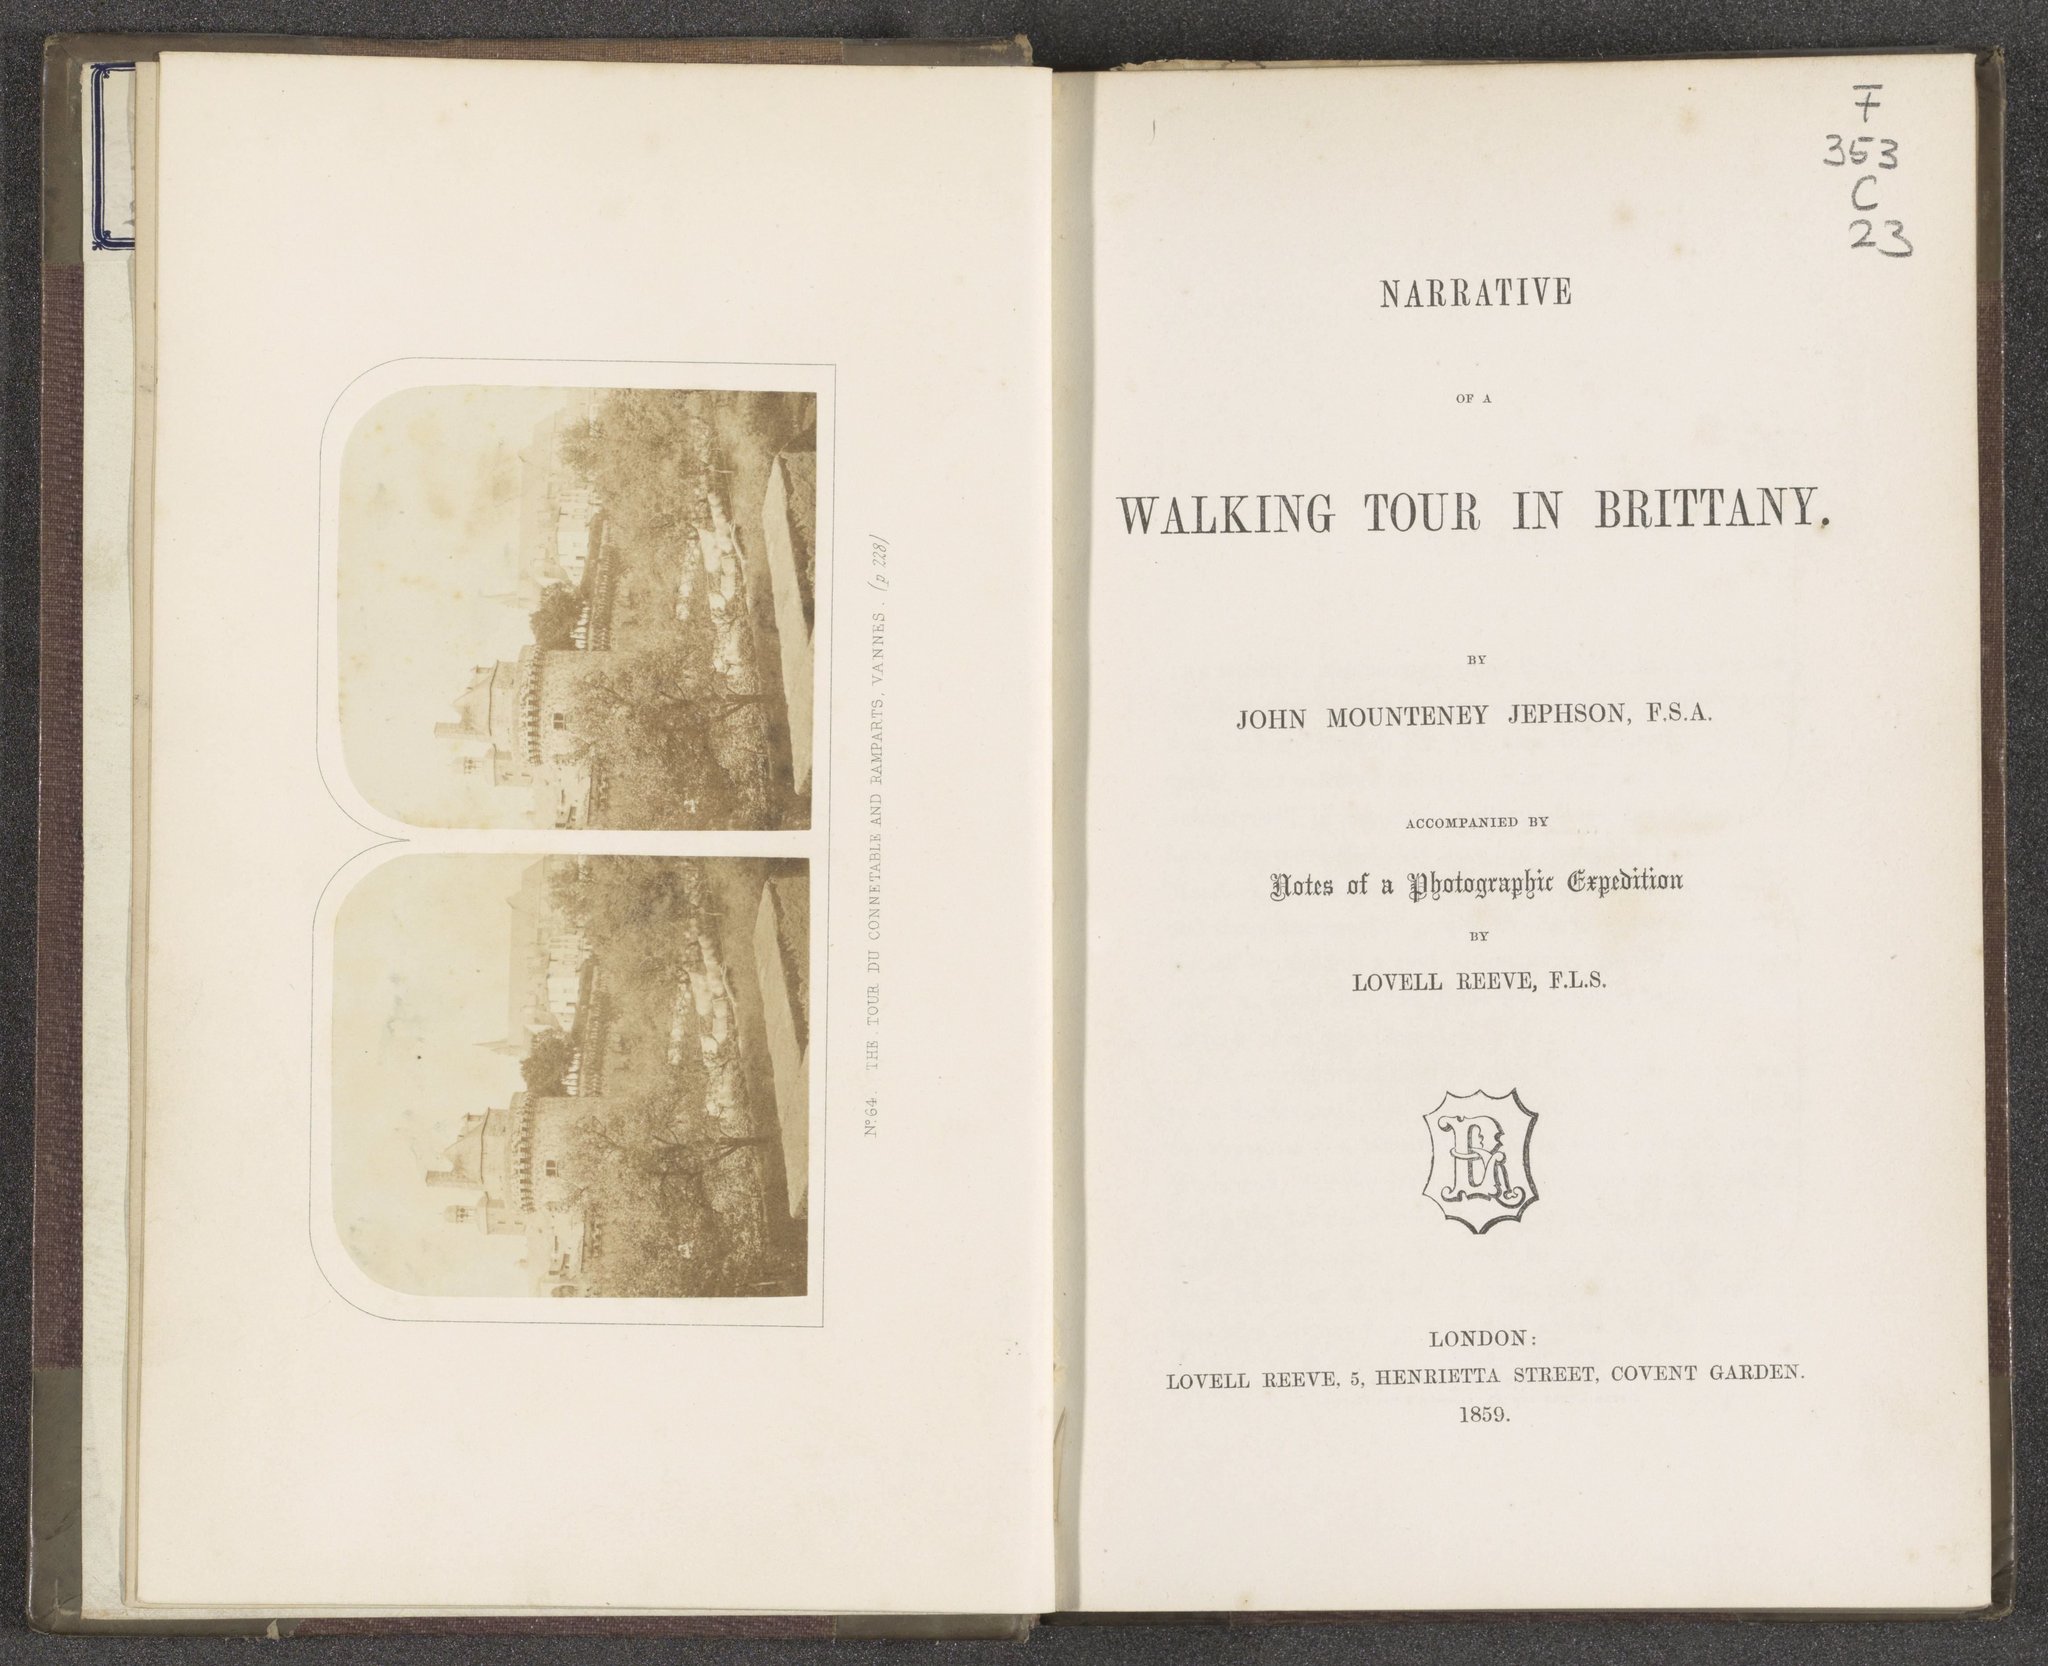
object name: page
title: The tour du Connetable and ramparts, Vannes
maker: taylor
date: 1850-1859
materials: paper, photographic support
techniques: albumen print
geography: vannes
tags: towers ~ fortified city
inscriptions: number: ‘No. 64.’